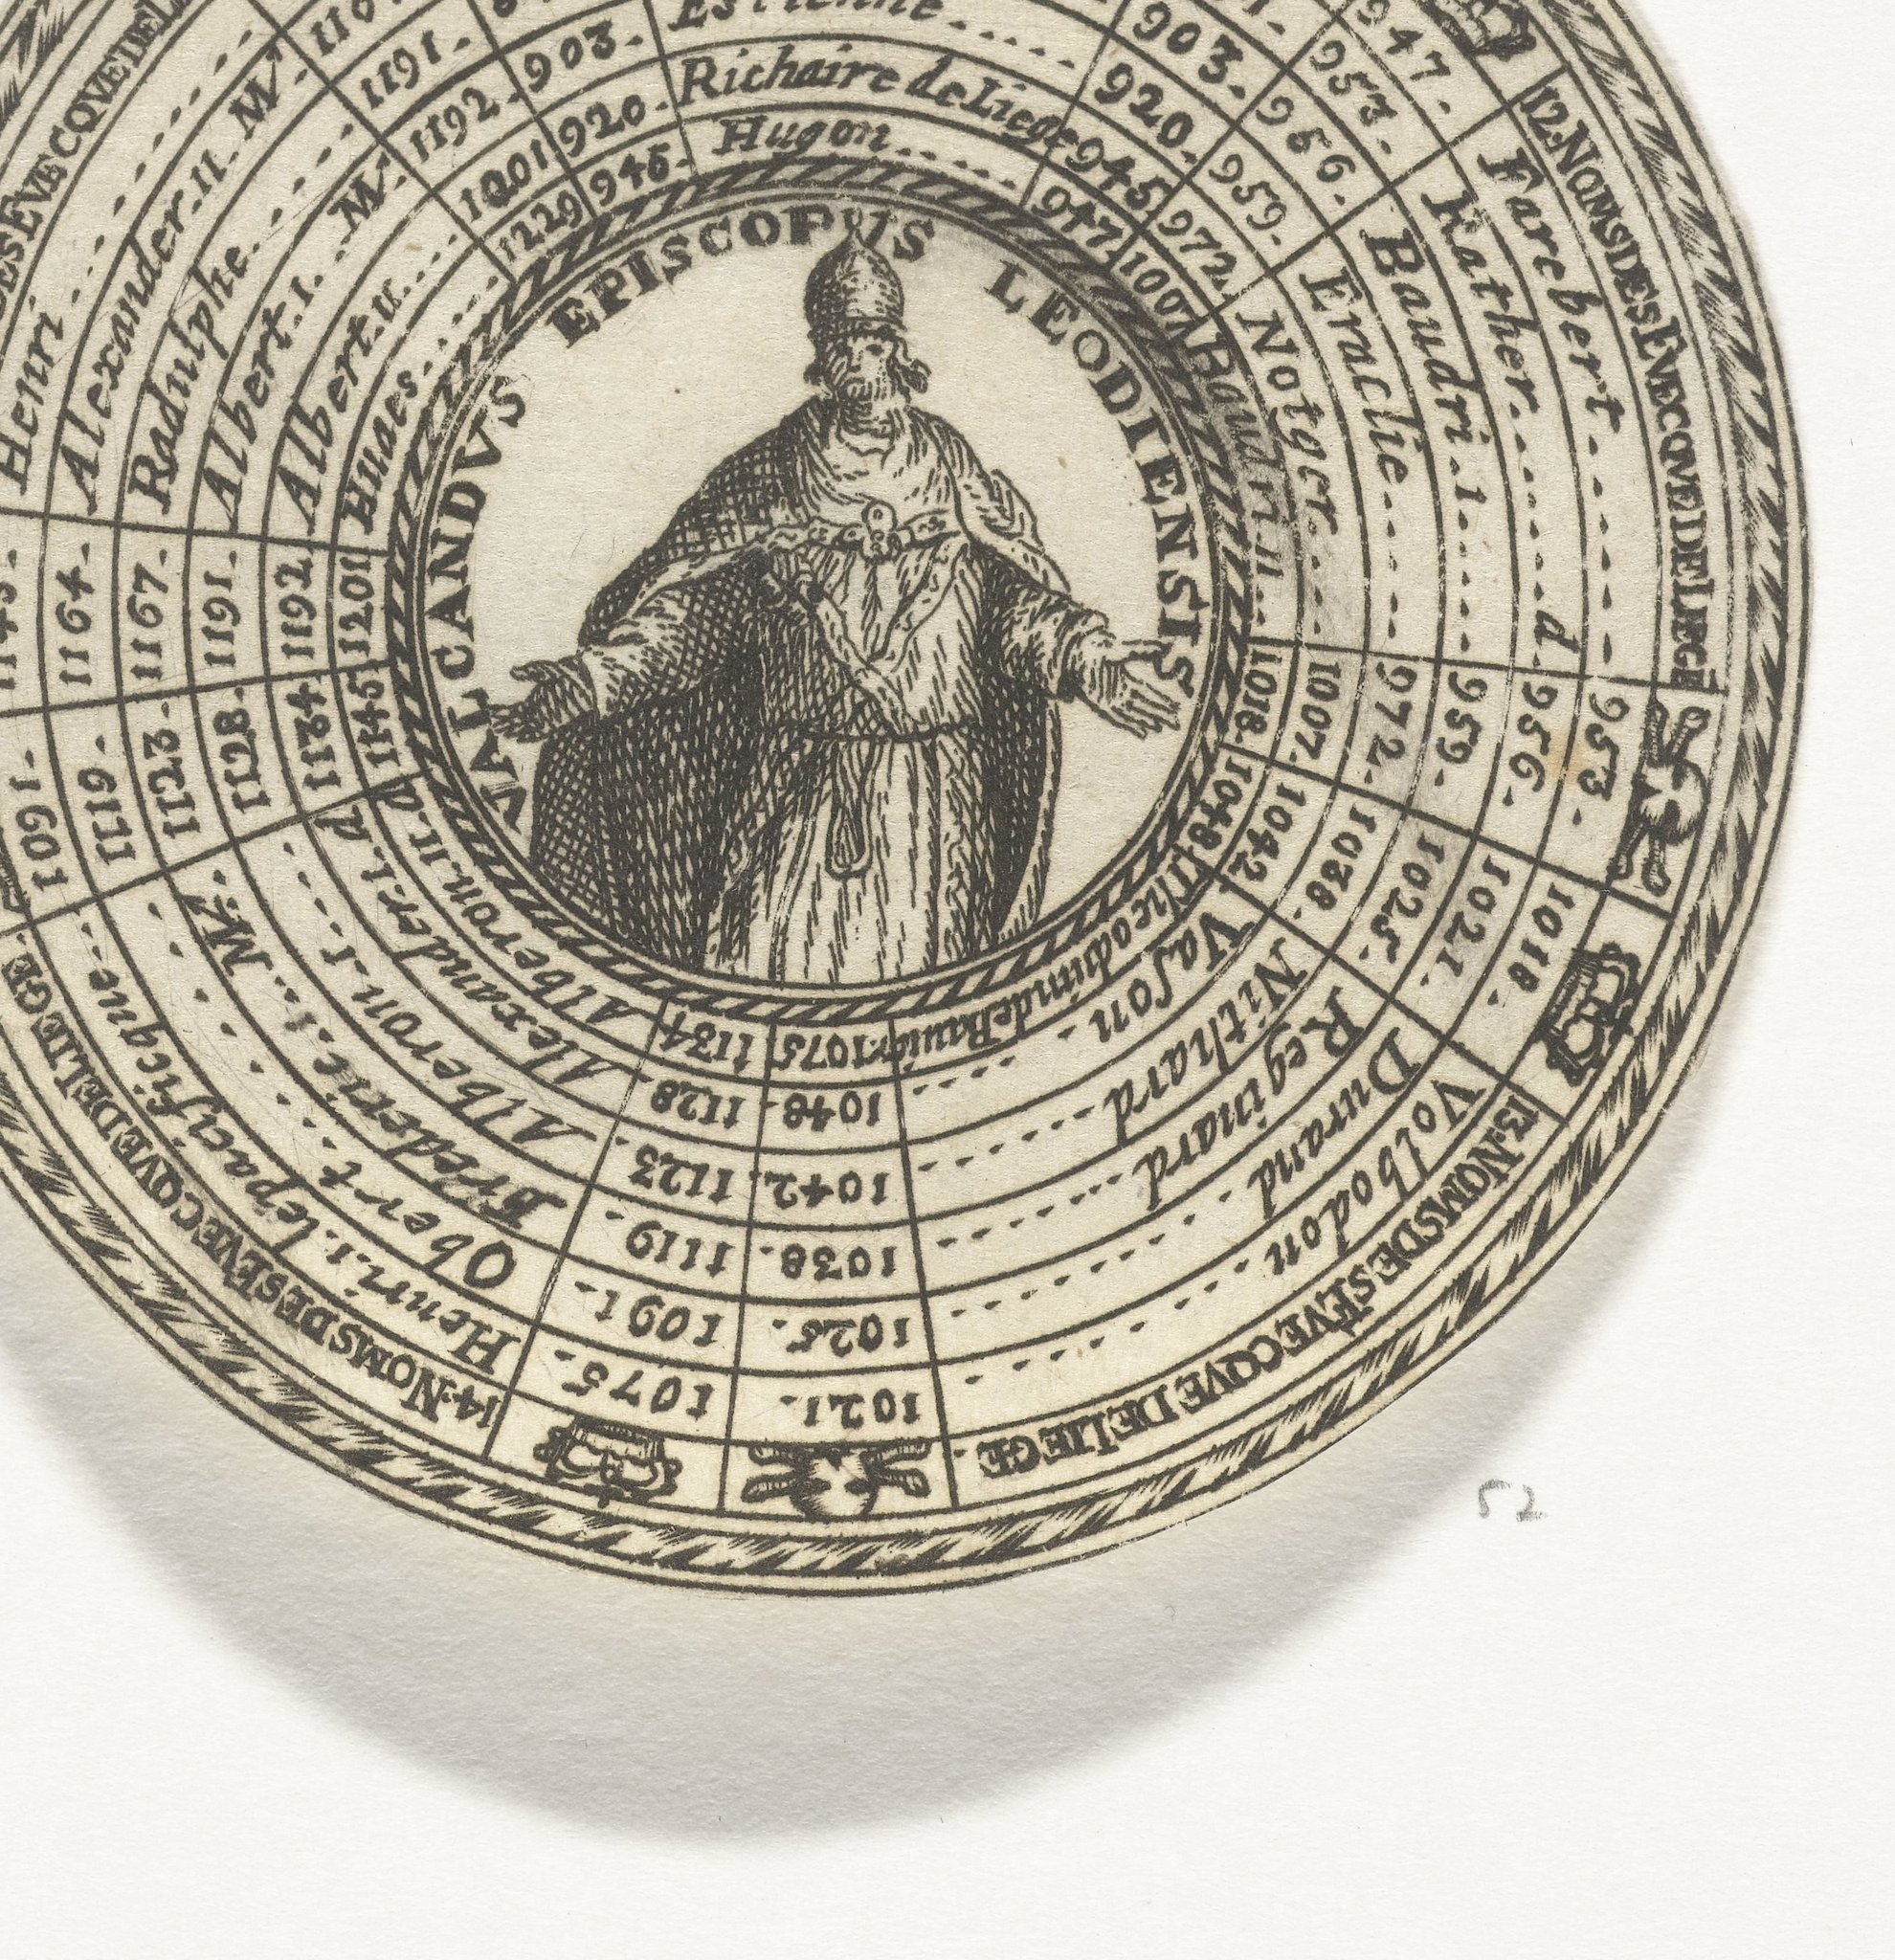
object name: print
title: Penning met het portret van bisschop Walcand en de namen van de bisschoppen van Luik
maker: Anonymous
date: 1685-1720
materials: paper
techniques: etching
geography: amsterdam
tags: archbishop, bishop, etc. (roman catholic), seal (symbol of sovereignty)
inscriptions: number: ‘55’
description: Ontwerp van een ronde penning met, in vijf concentrische cirkels, de namen van de bisschoppen van Luik en hun regeringsjaren, beginnende bij Walcand en eindigend bij bisschop Hugo II. In het midden van de penning het portret van bisschop Walcand.